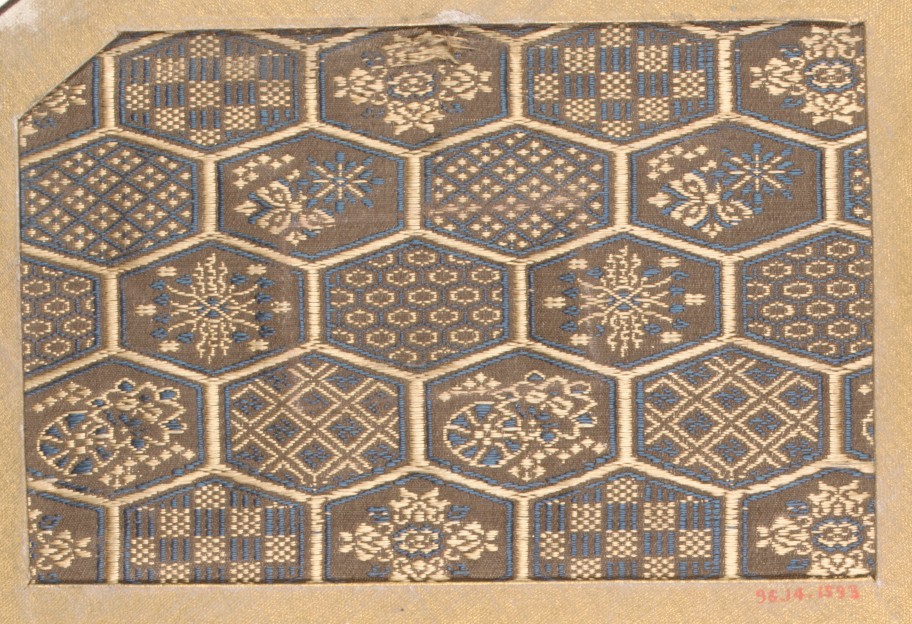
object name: piece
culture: japanese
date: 1701-1900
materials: silk